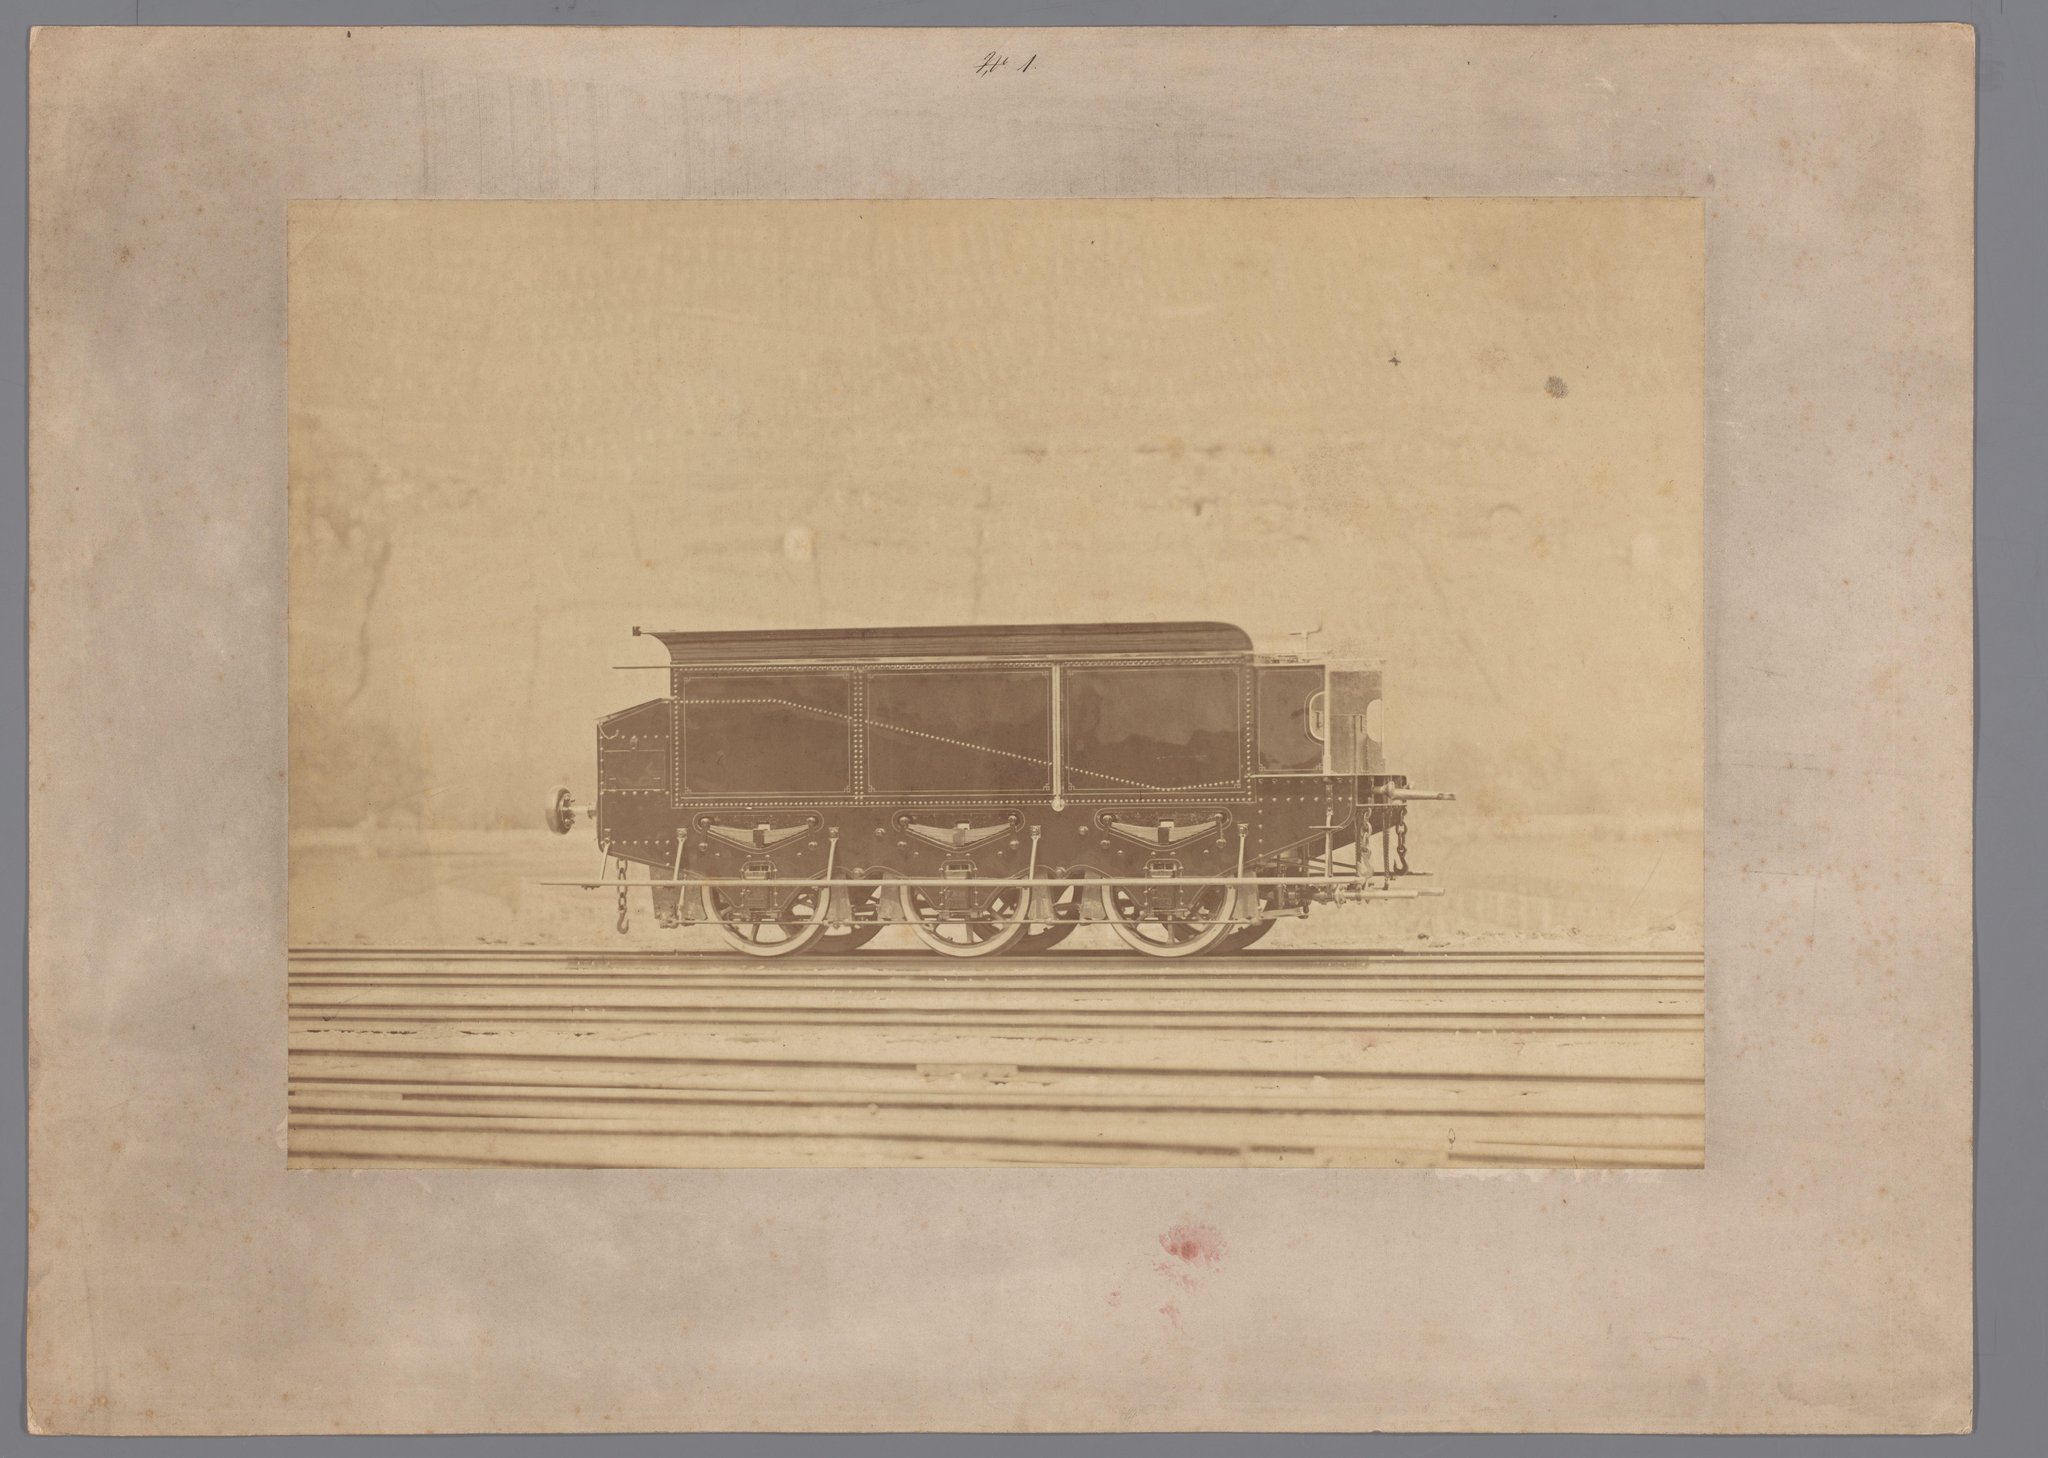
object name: photograph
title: Open treinwagon op spoorrails, Hanau [?], Duitsland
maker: Anonymous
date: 1860-1870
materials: cardboard, paper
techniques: albumen print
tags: germany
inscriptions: inscription: ‘no. 1’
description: Open treinwagon op spoorrails, afgebeeld in een kale buitenruimte.